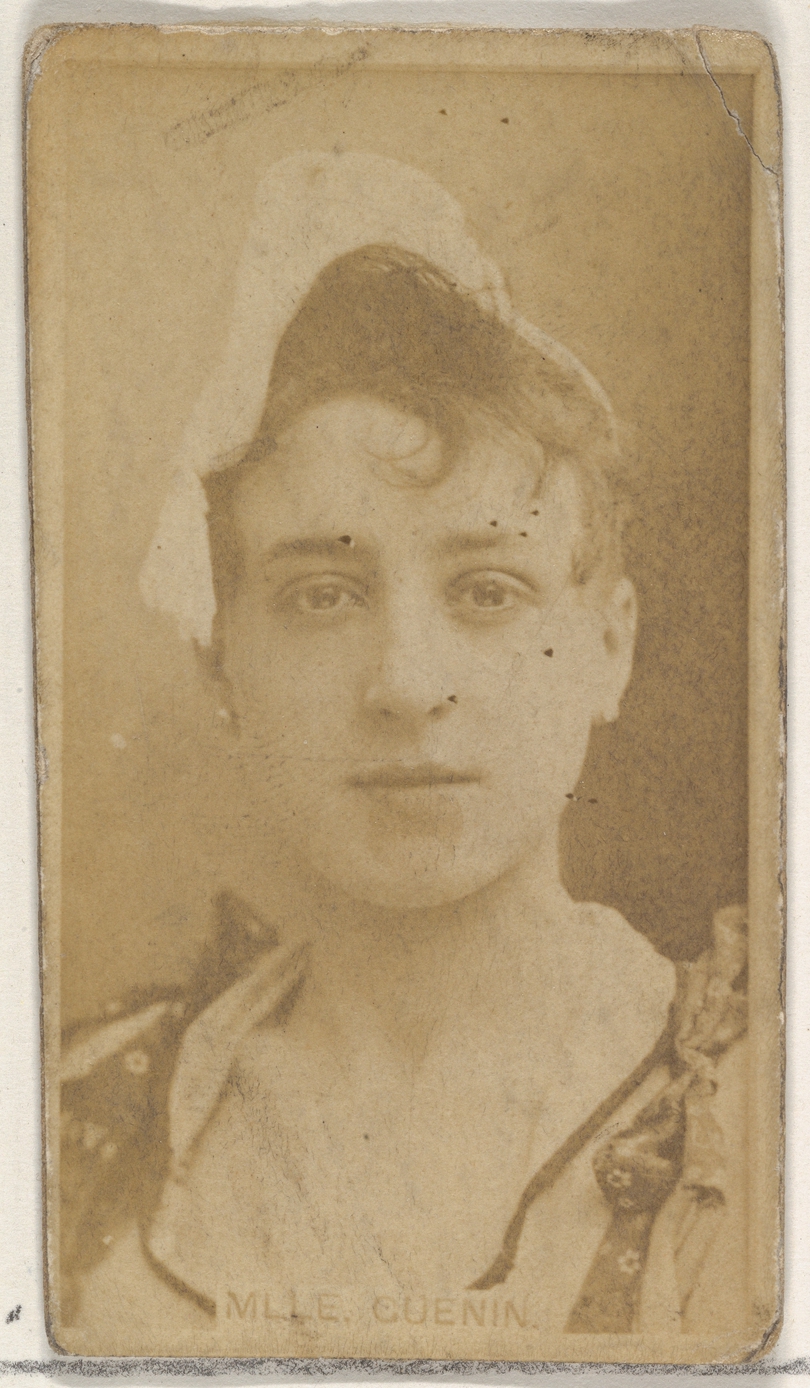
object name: photograph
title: Mlle. Guenin, from the Actors and Actresses series (N45, Type 8) for Virginia Brights Cigarettes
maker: allen & ginter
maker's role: publisher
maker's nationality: american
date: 1888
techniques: albumen silver print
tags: portraits,women,actresses